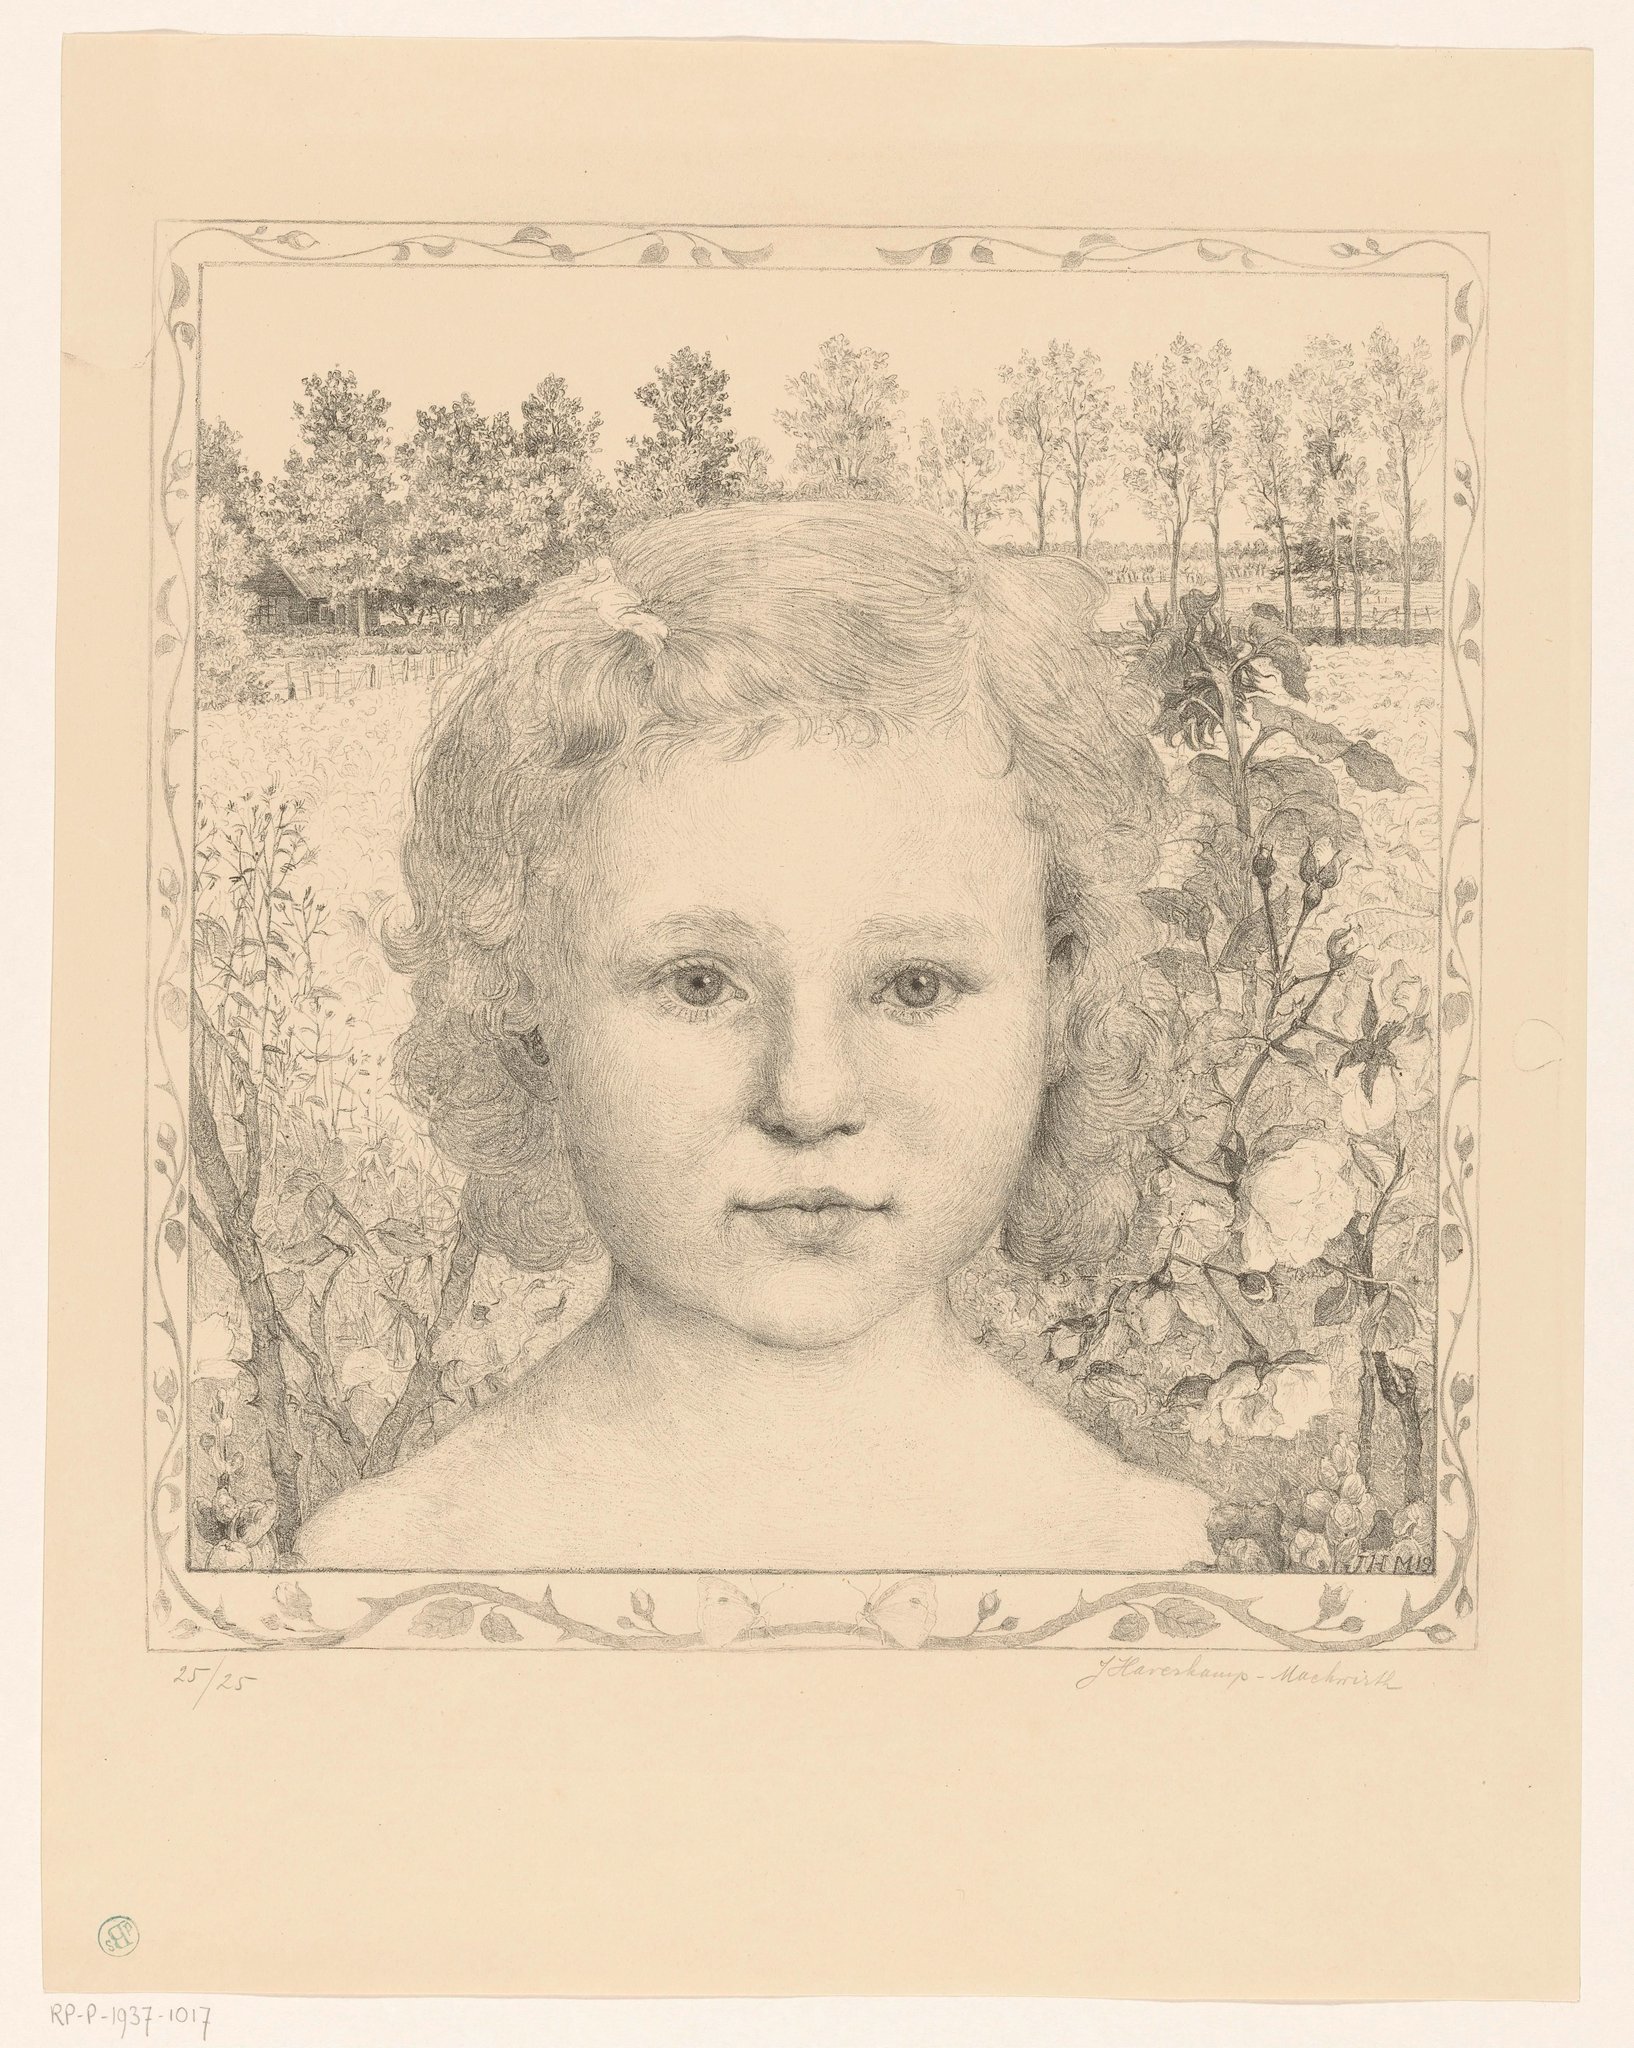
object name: print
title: Portret van een onbekend meisje in landschap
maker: johanna haverkamp-mackwirth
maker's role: print maker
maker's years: 1874-1945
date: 1919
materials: paper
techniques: lithograph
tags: landscapes in the temperate zone, girl (child between toddler and youth), flowers: rose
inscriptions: collector's mark: Lugt 2228, collector's mark: Lugt 2760, collector's mark: Lugt 733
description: Naast het gezicht van het meisje groeien rozen. Achter haar is een landschap met boerderij te zien.